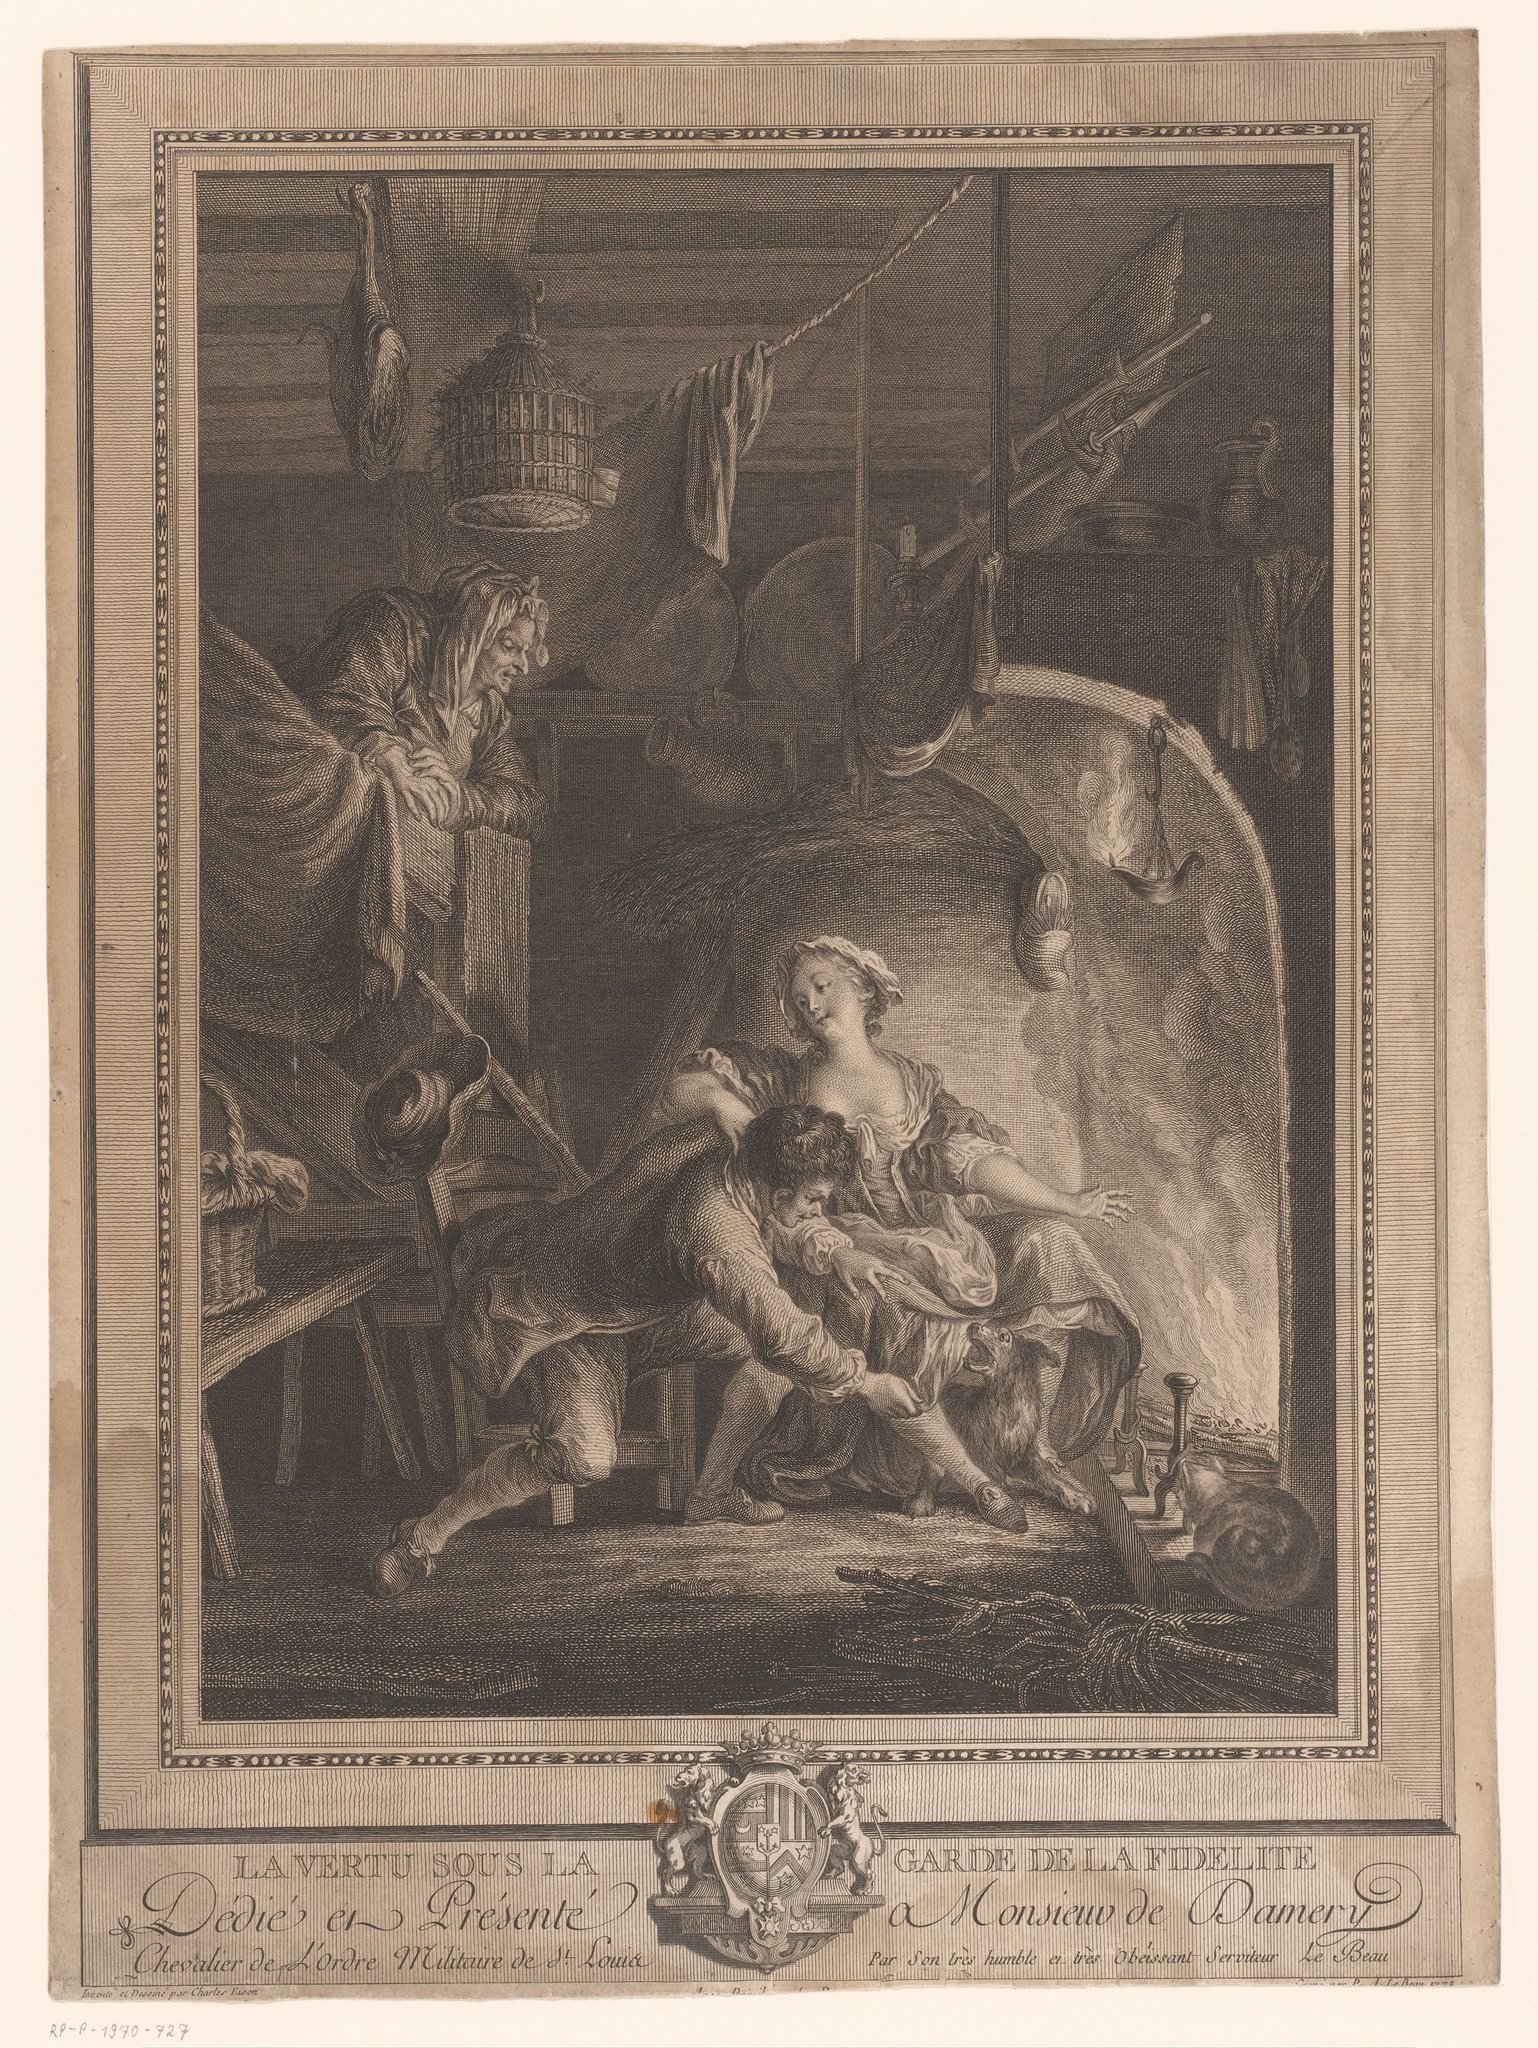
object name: print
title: Koppel aan het haardvuur onder toezicht van een hond en een oude vrouw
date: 1772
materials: paper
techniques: engraving, etching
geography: france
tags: open hearth, fire-place, courting, dog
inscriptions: number: ‘No. 2482.’, collector's mark: Lugt 2228